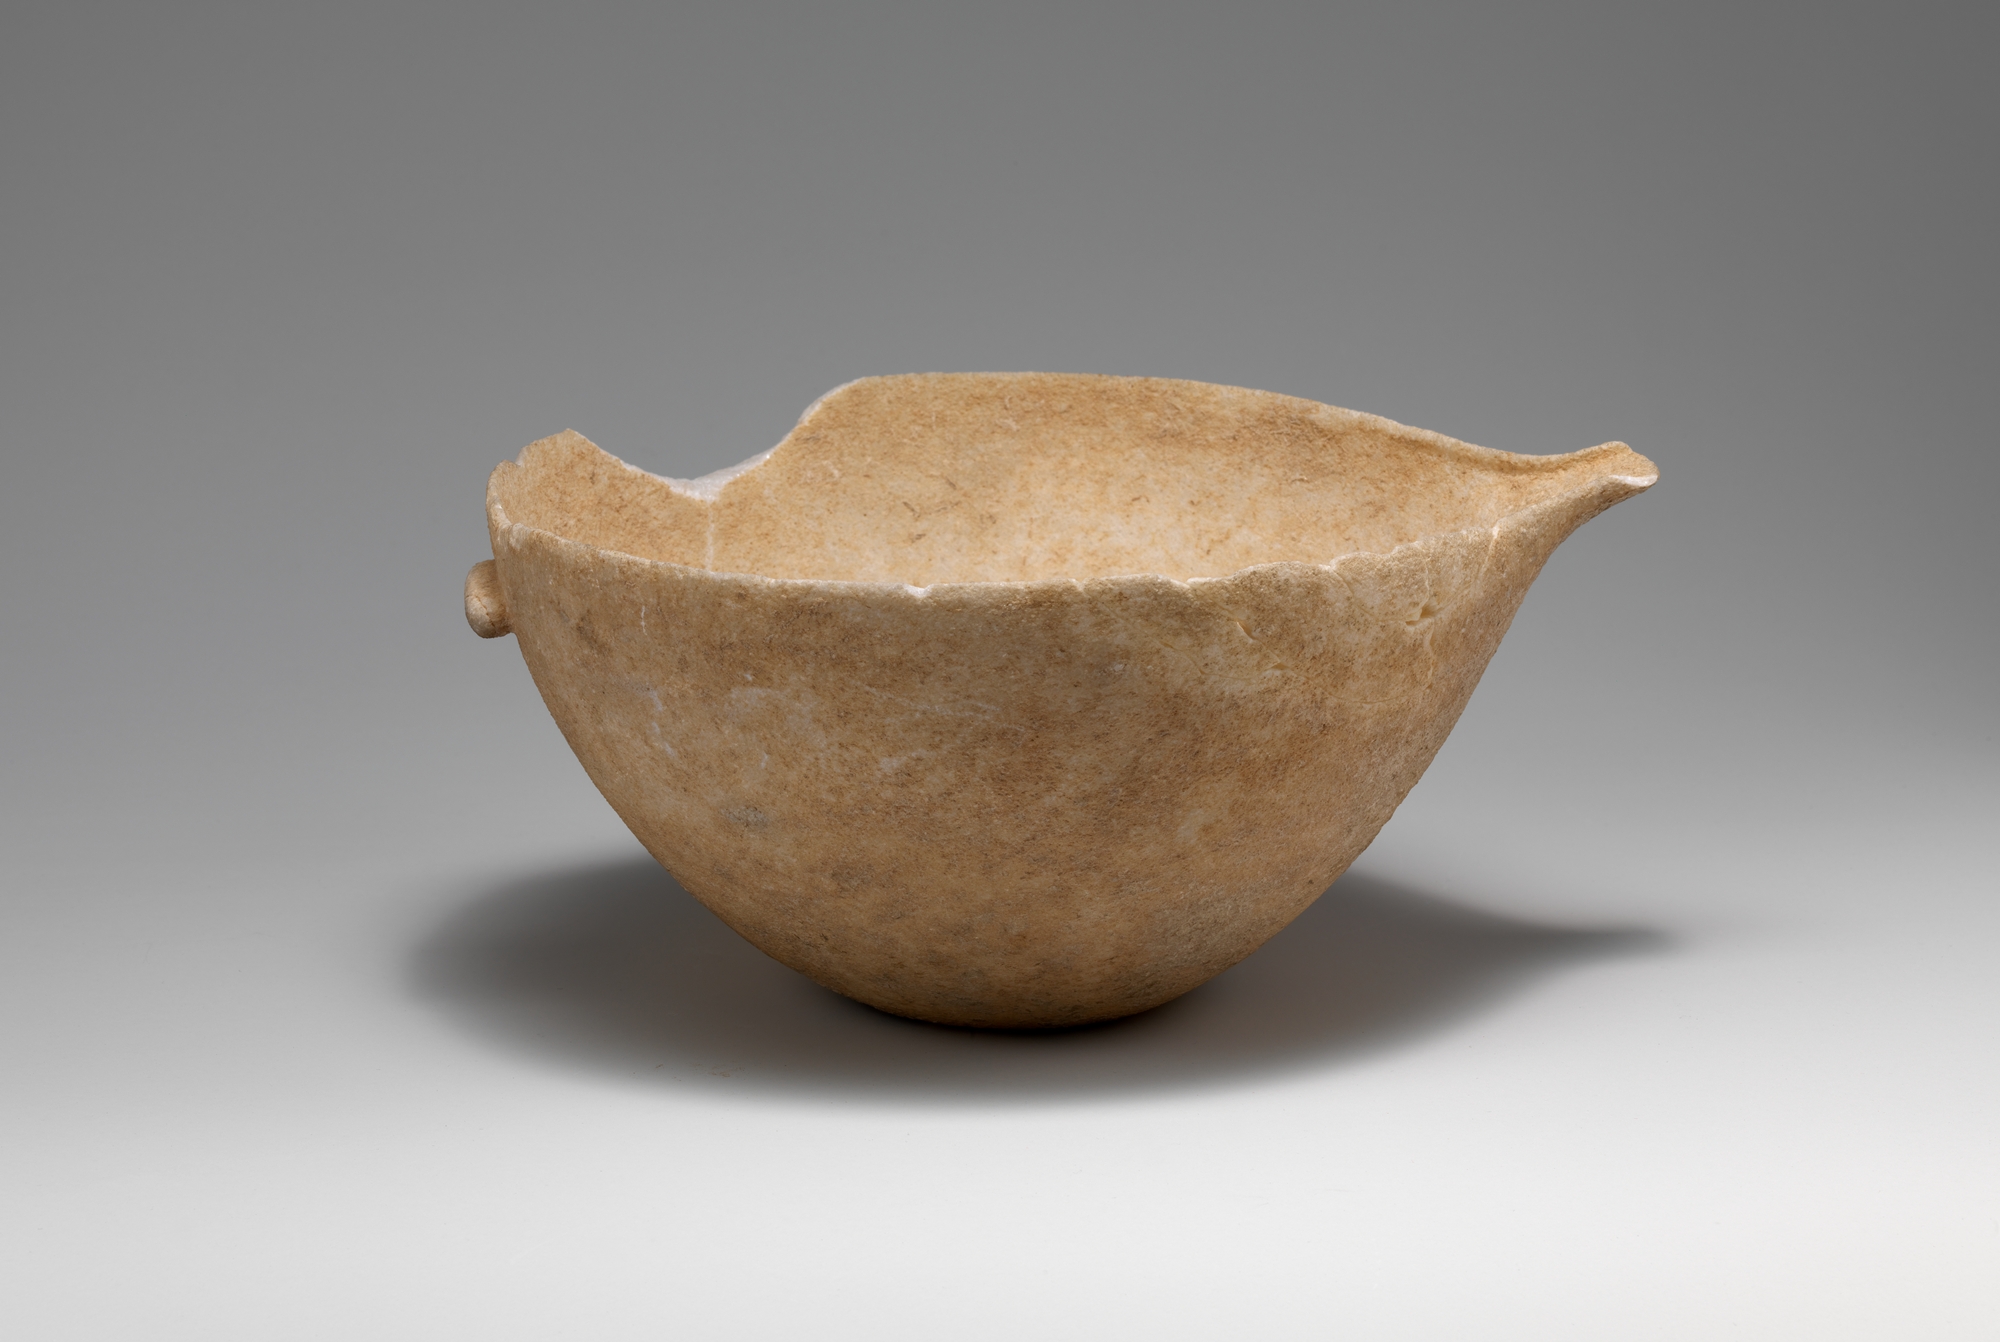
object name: bowl with spout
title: Marble spouted bowl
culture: cycladic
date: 2700-2200 BCE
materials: marble